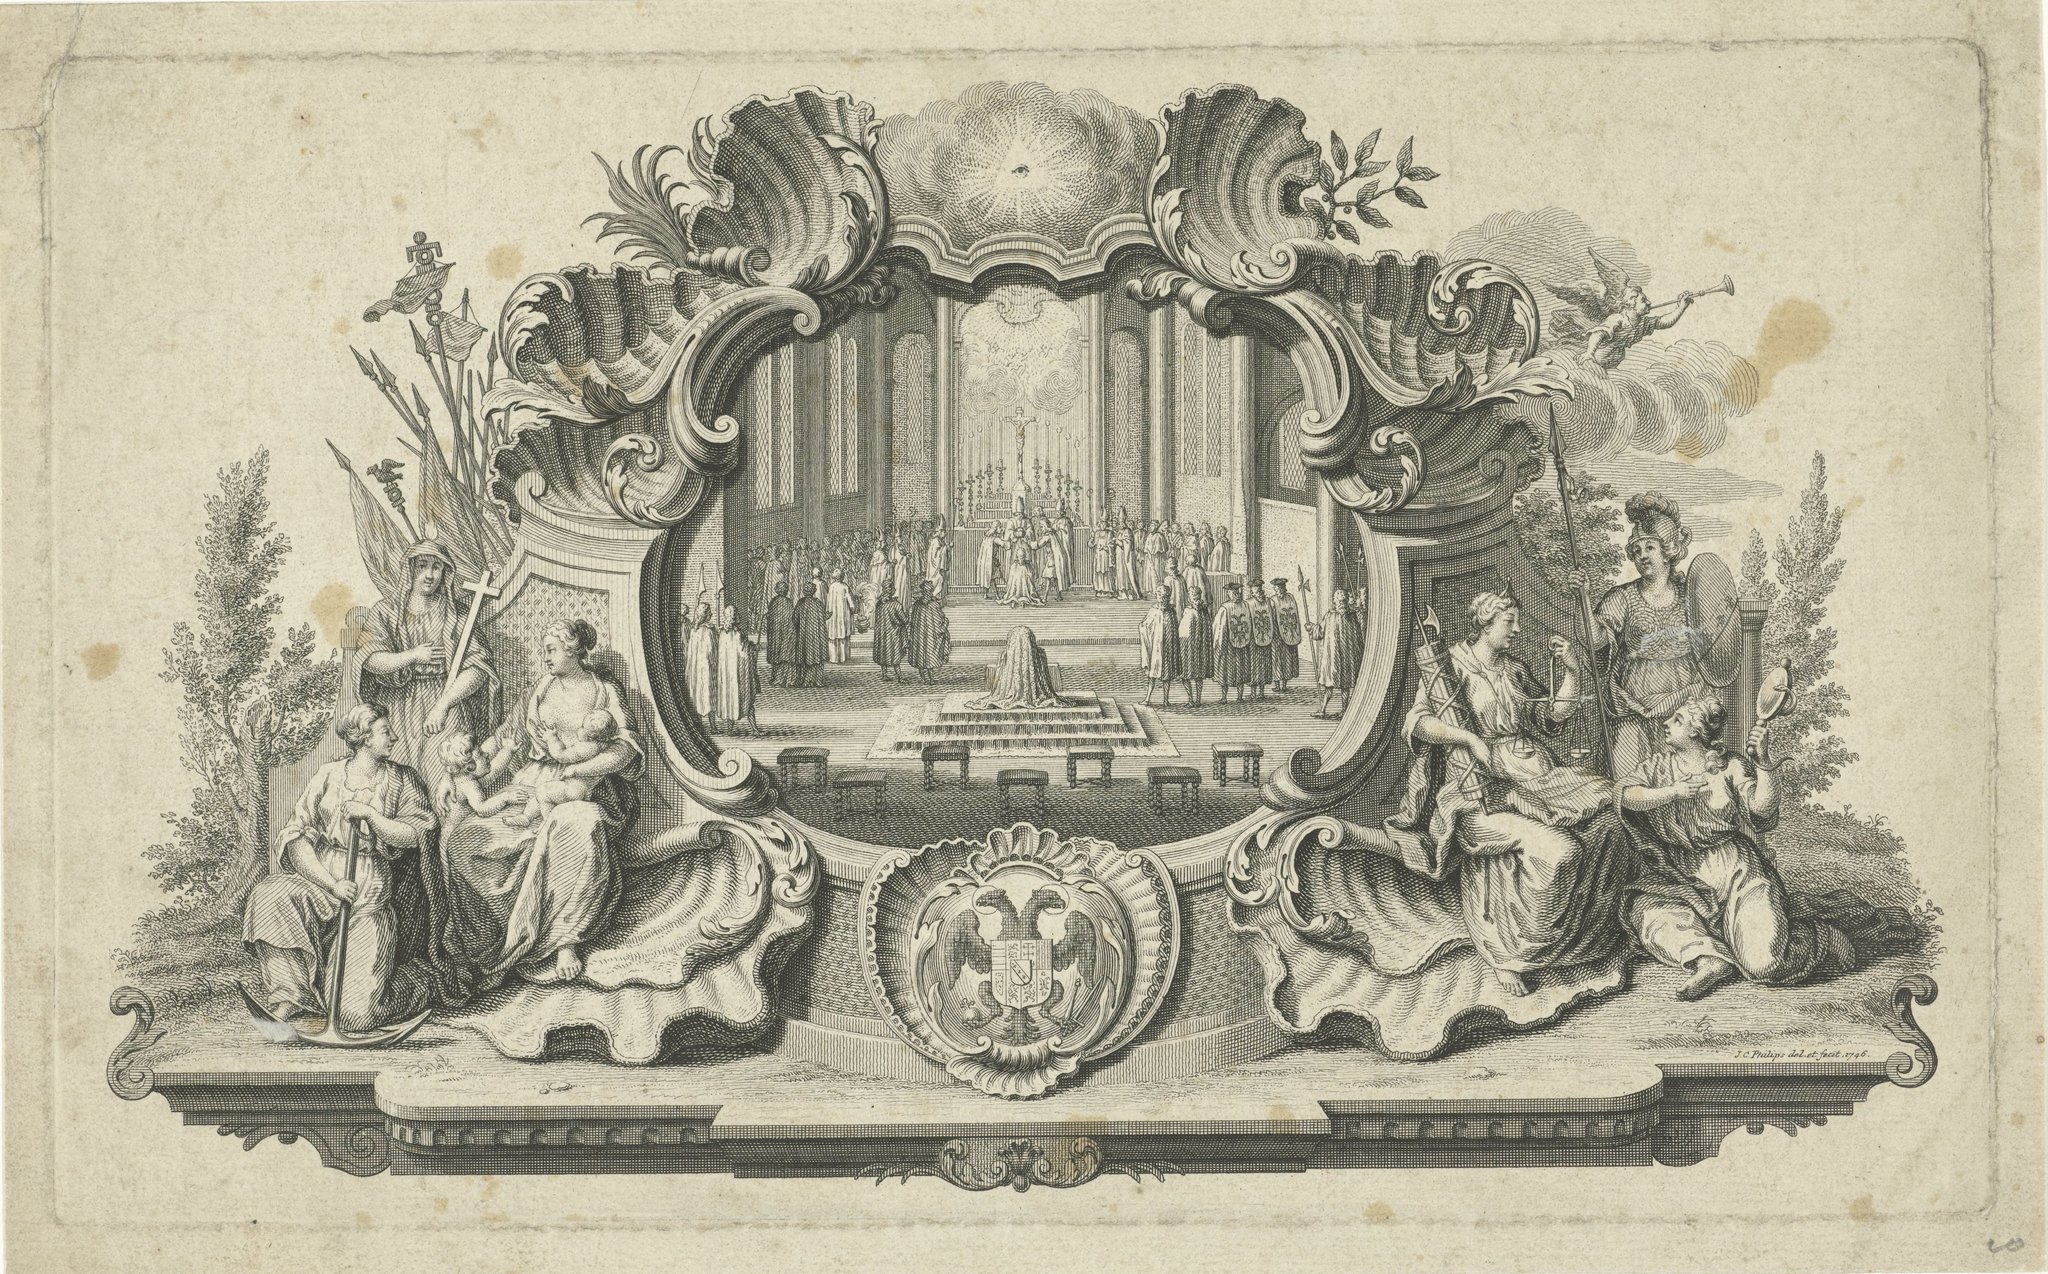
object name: print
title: Vignet met de kroning van Frans I Stefan tot keizer, 1745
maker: jan caspar philips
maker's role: draughtsman, print maker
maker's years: 1700-1775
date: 1746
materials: paper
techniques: engraving, etching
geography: amsterdam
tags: frans i stefan (duits keizer), 'sapientia' and the seven virtues, i.e. the three theological and the four cardinal virtues, during the coronation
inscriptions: collector's mark: Lugt 2228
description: Gebruikt als titelprent voor het plaatwerk: Description des principales rejouissances, faites à la Haye, a l'occasion du couronnnement de ... François I / Beschryving der voornaamste vreugde-bedryven in 's Gravenhage ter gelegenheid van de krooning van zyne keizerlyke majesteit Franciscus I. Anthonie de Groot & Zoonen, Den Haag: 1747.